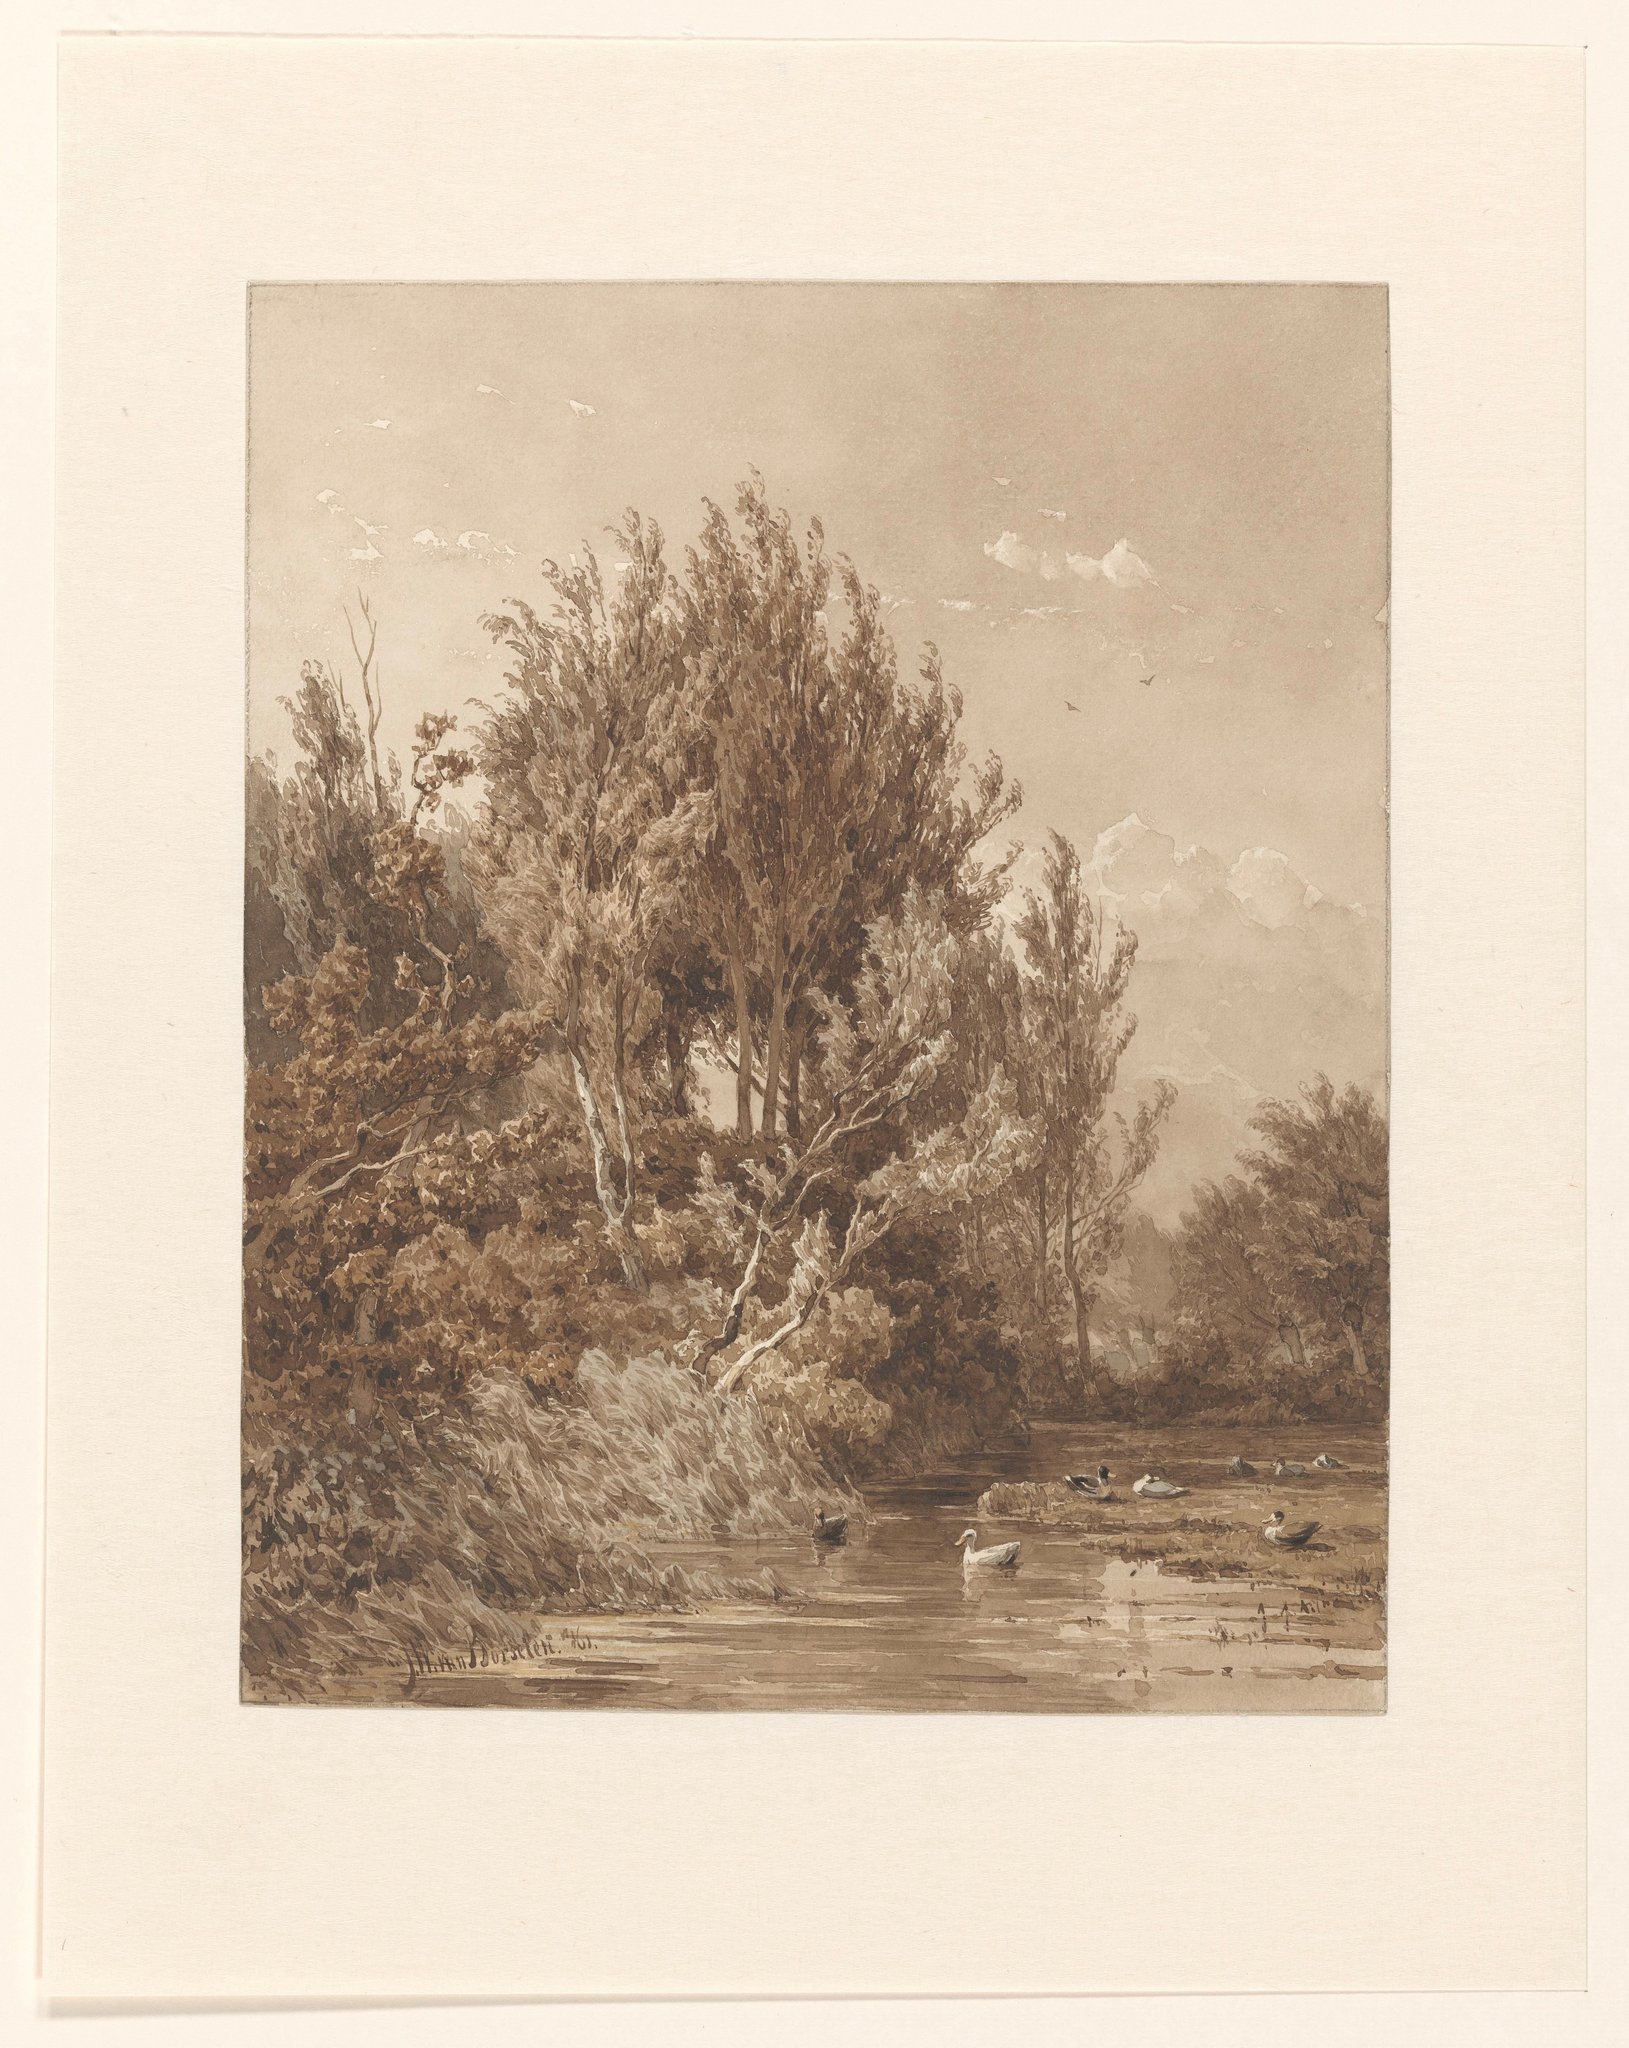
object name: drawing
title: Landschap met water met eenden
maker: jan willem van borselen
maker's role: draughtsman, print maker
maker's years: 1825-1892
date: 1861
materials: paper, pencil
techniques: brush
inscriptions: date: ‘61’